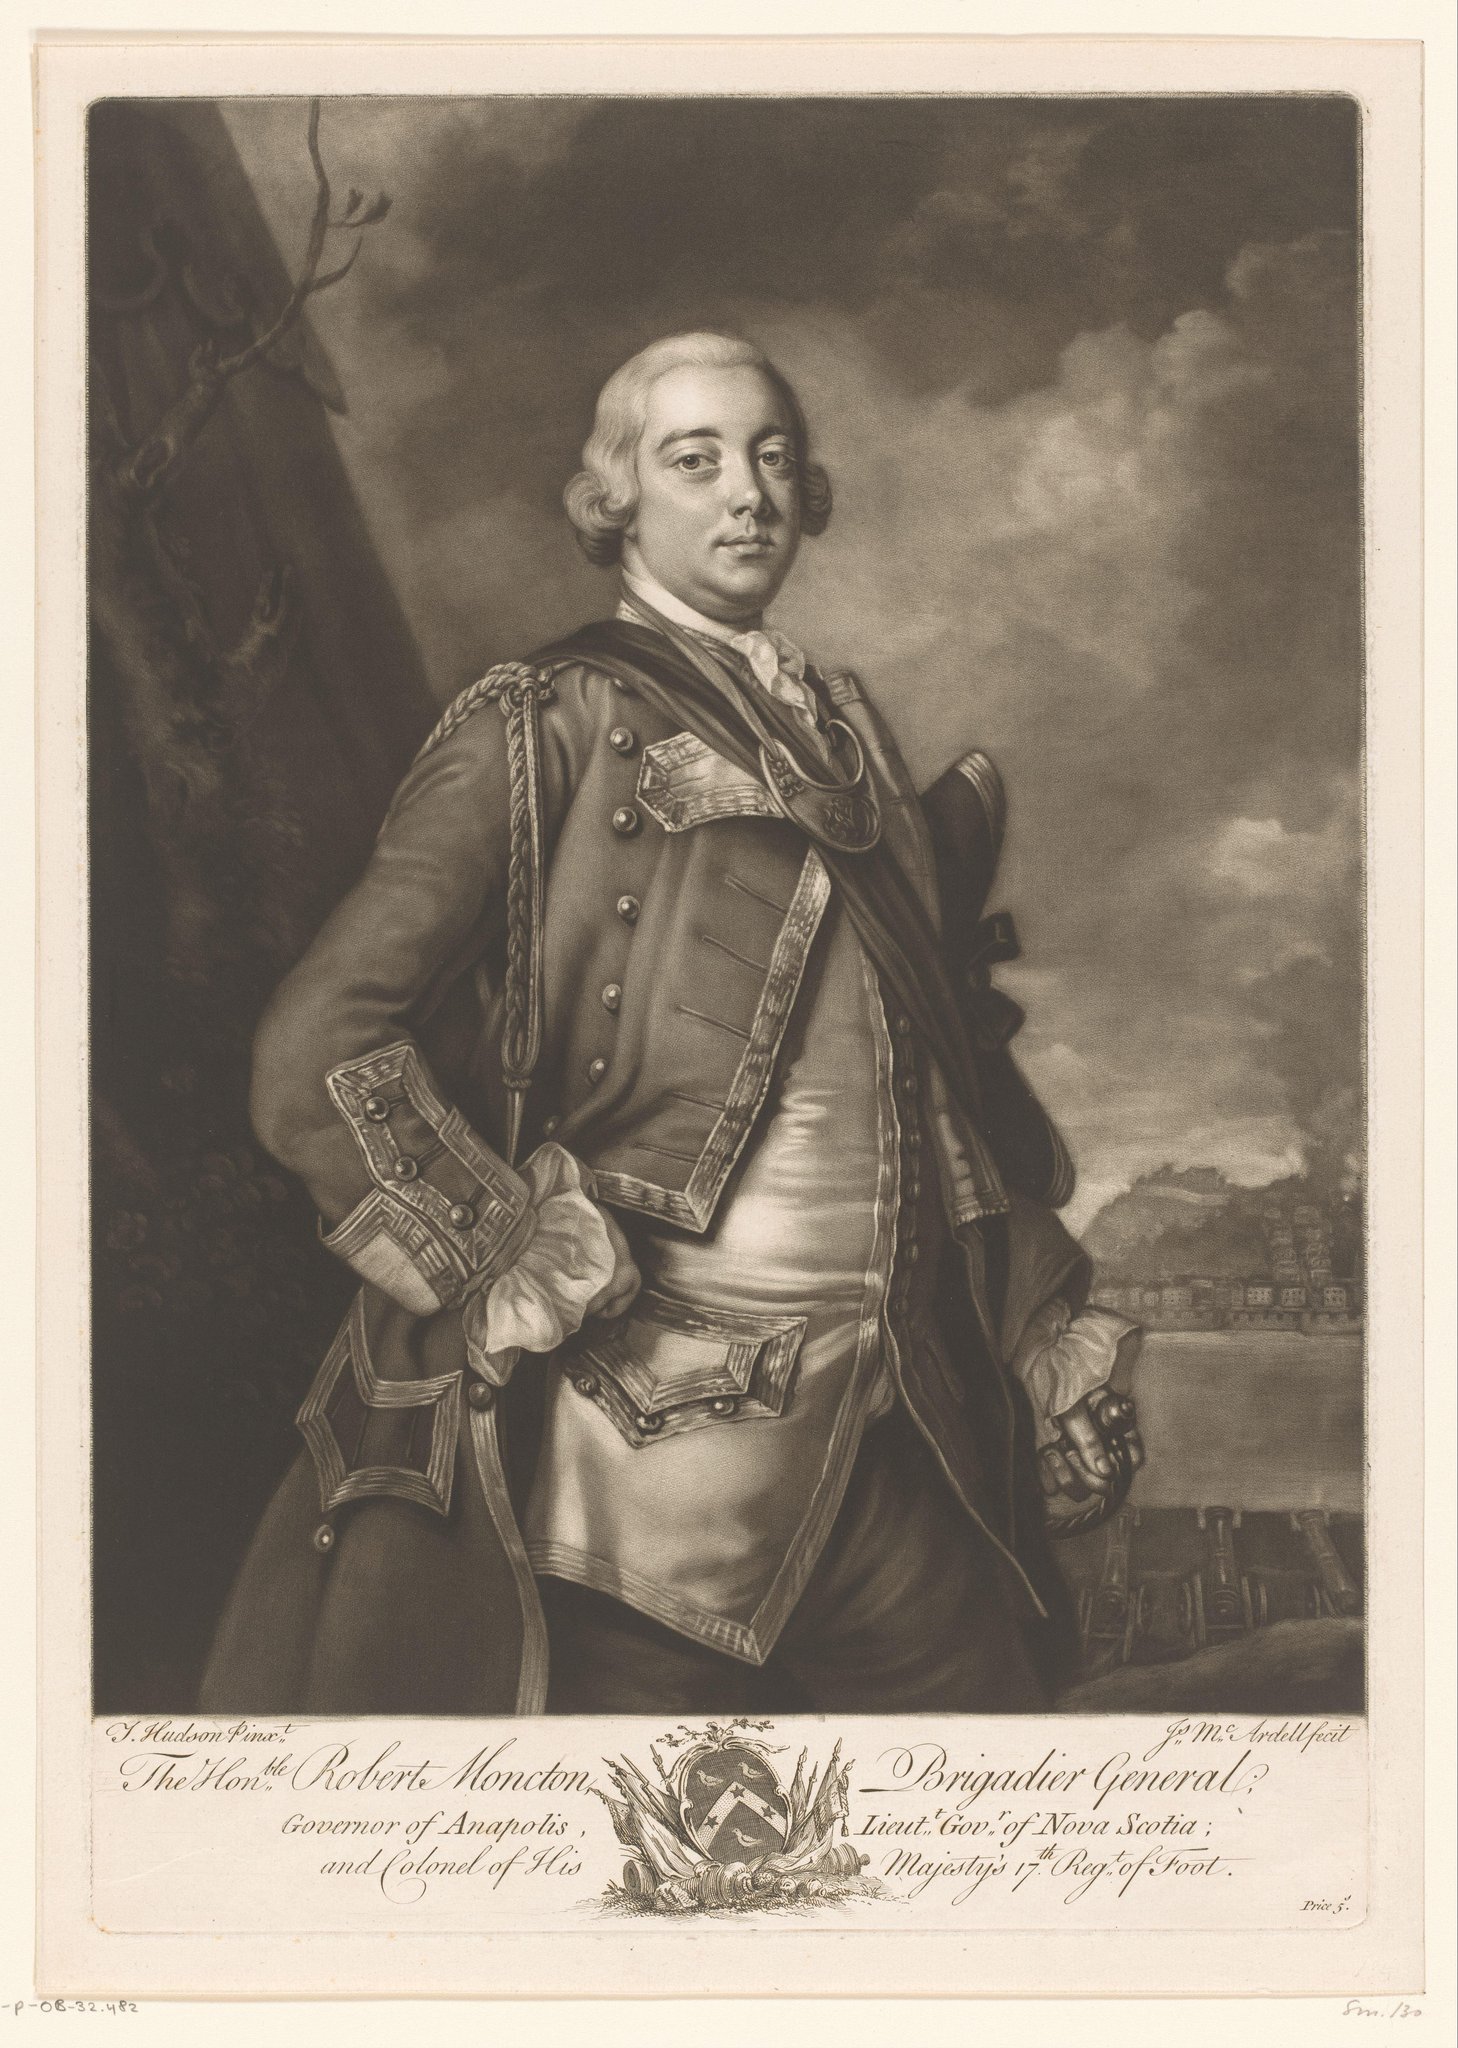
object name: print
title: The Honble. Robert Moncton, Brigadier General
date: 1755-1765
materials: paper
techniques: mezzotint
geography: london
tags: robert monckton, commander-in-chief, general, marshal, historical persons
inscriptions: collector's mark: Lugt 240